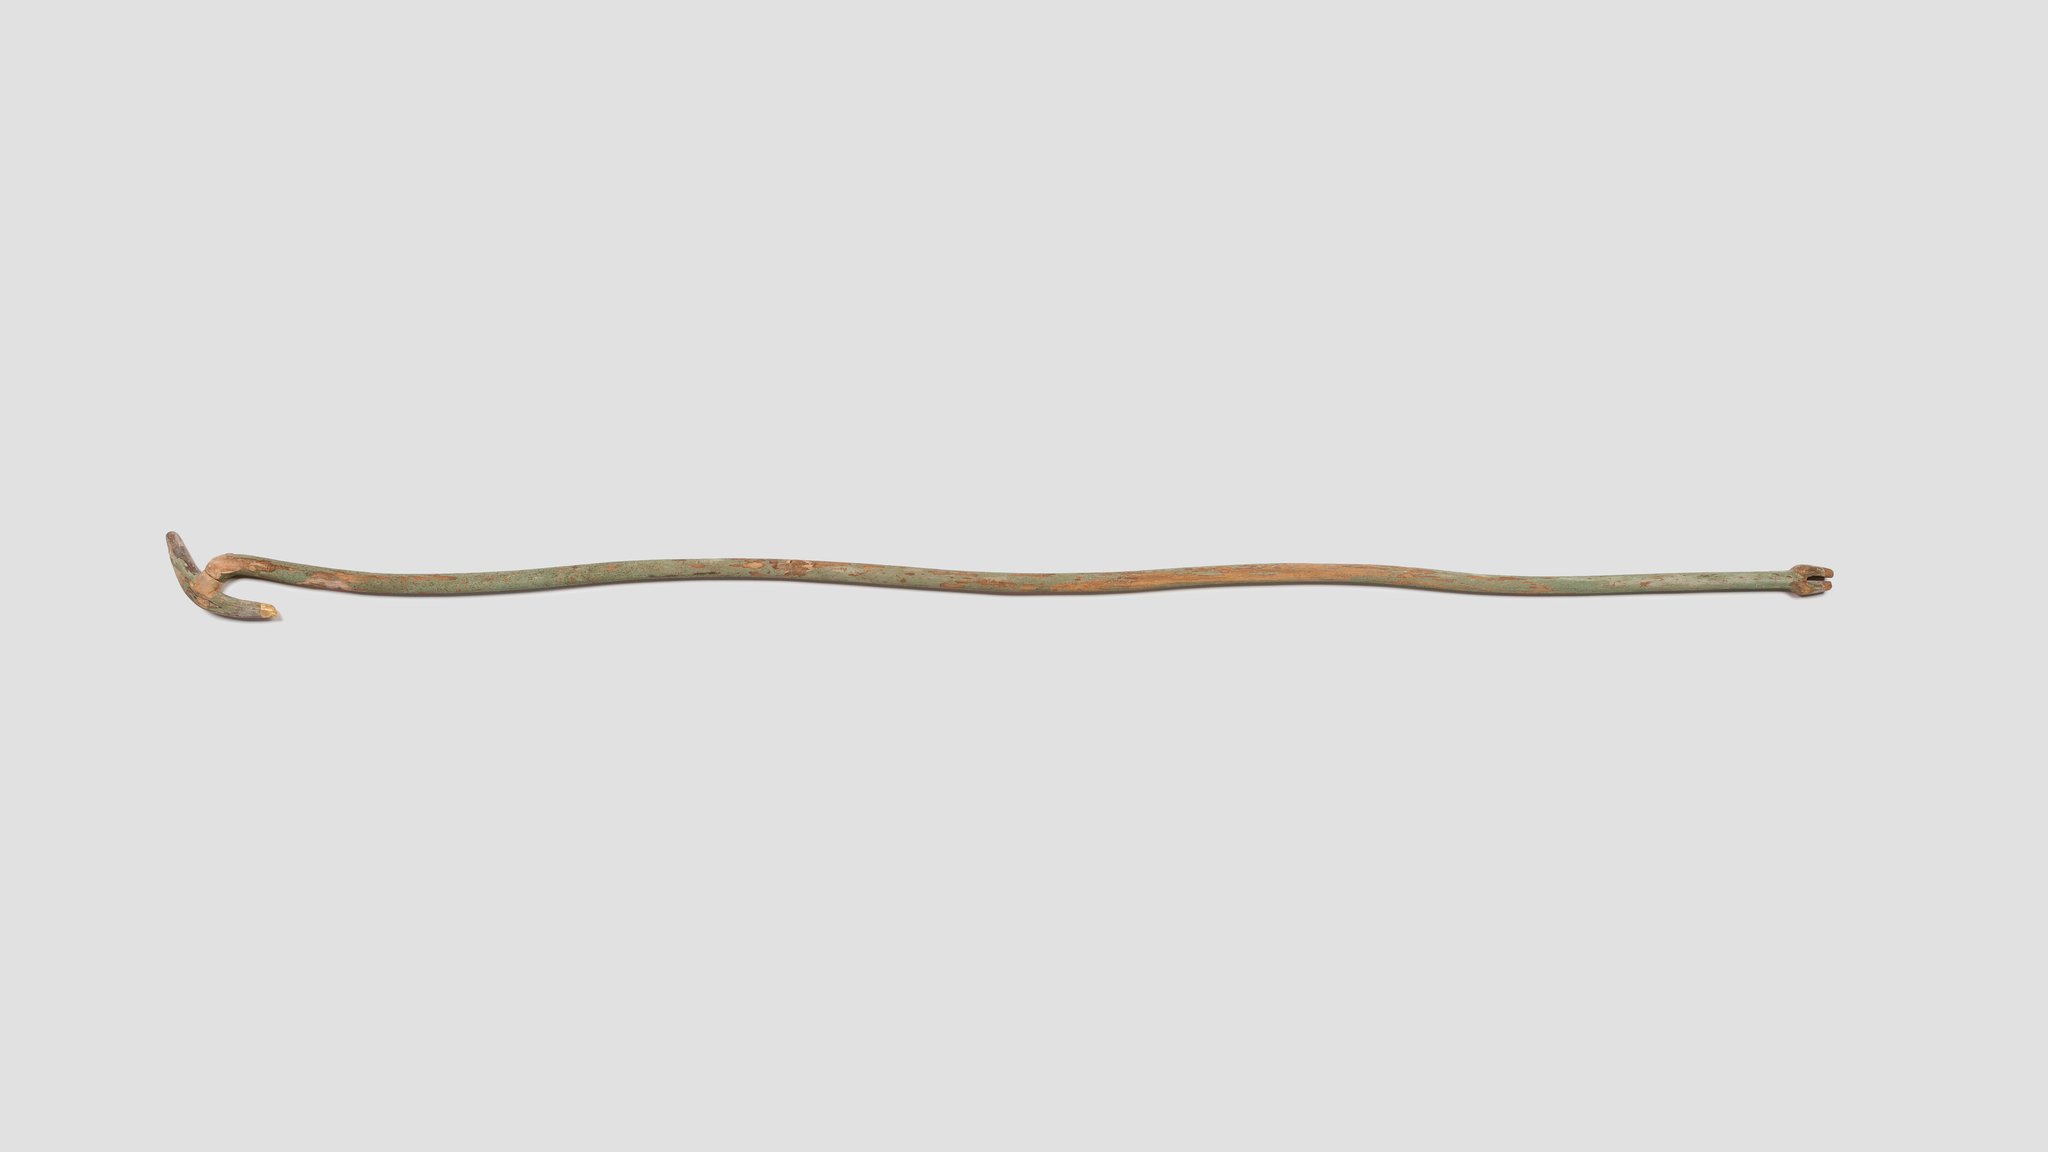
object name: scepter, djam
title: Djam scepter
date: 1981-1802 BCE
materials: wood